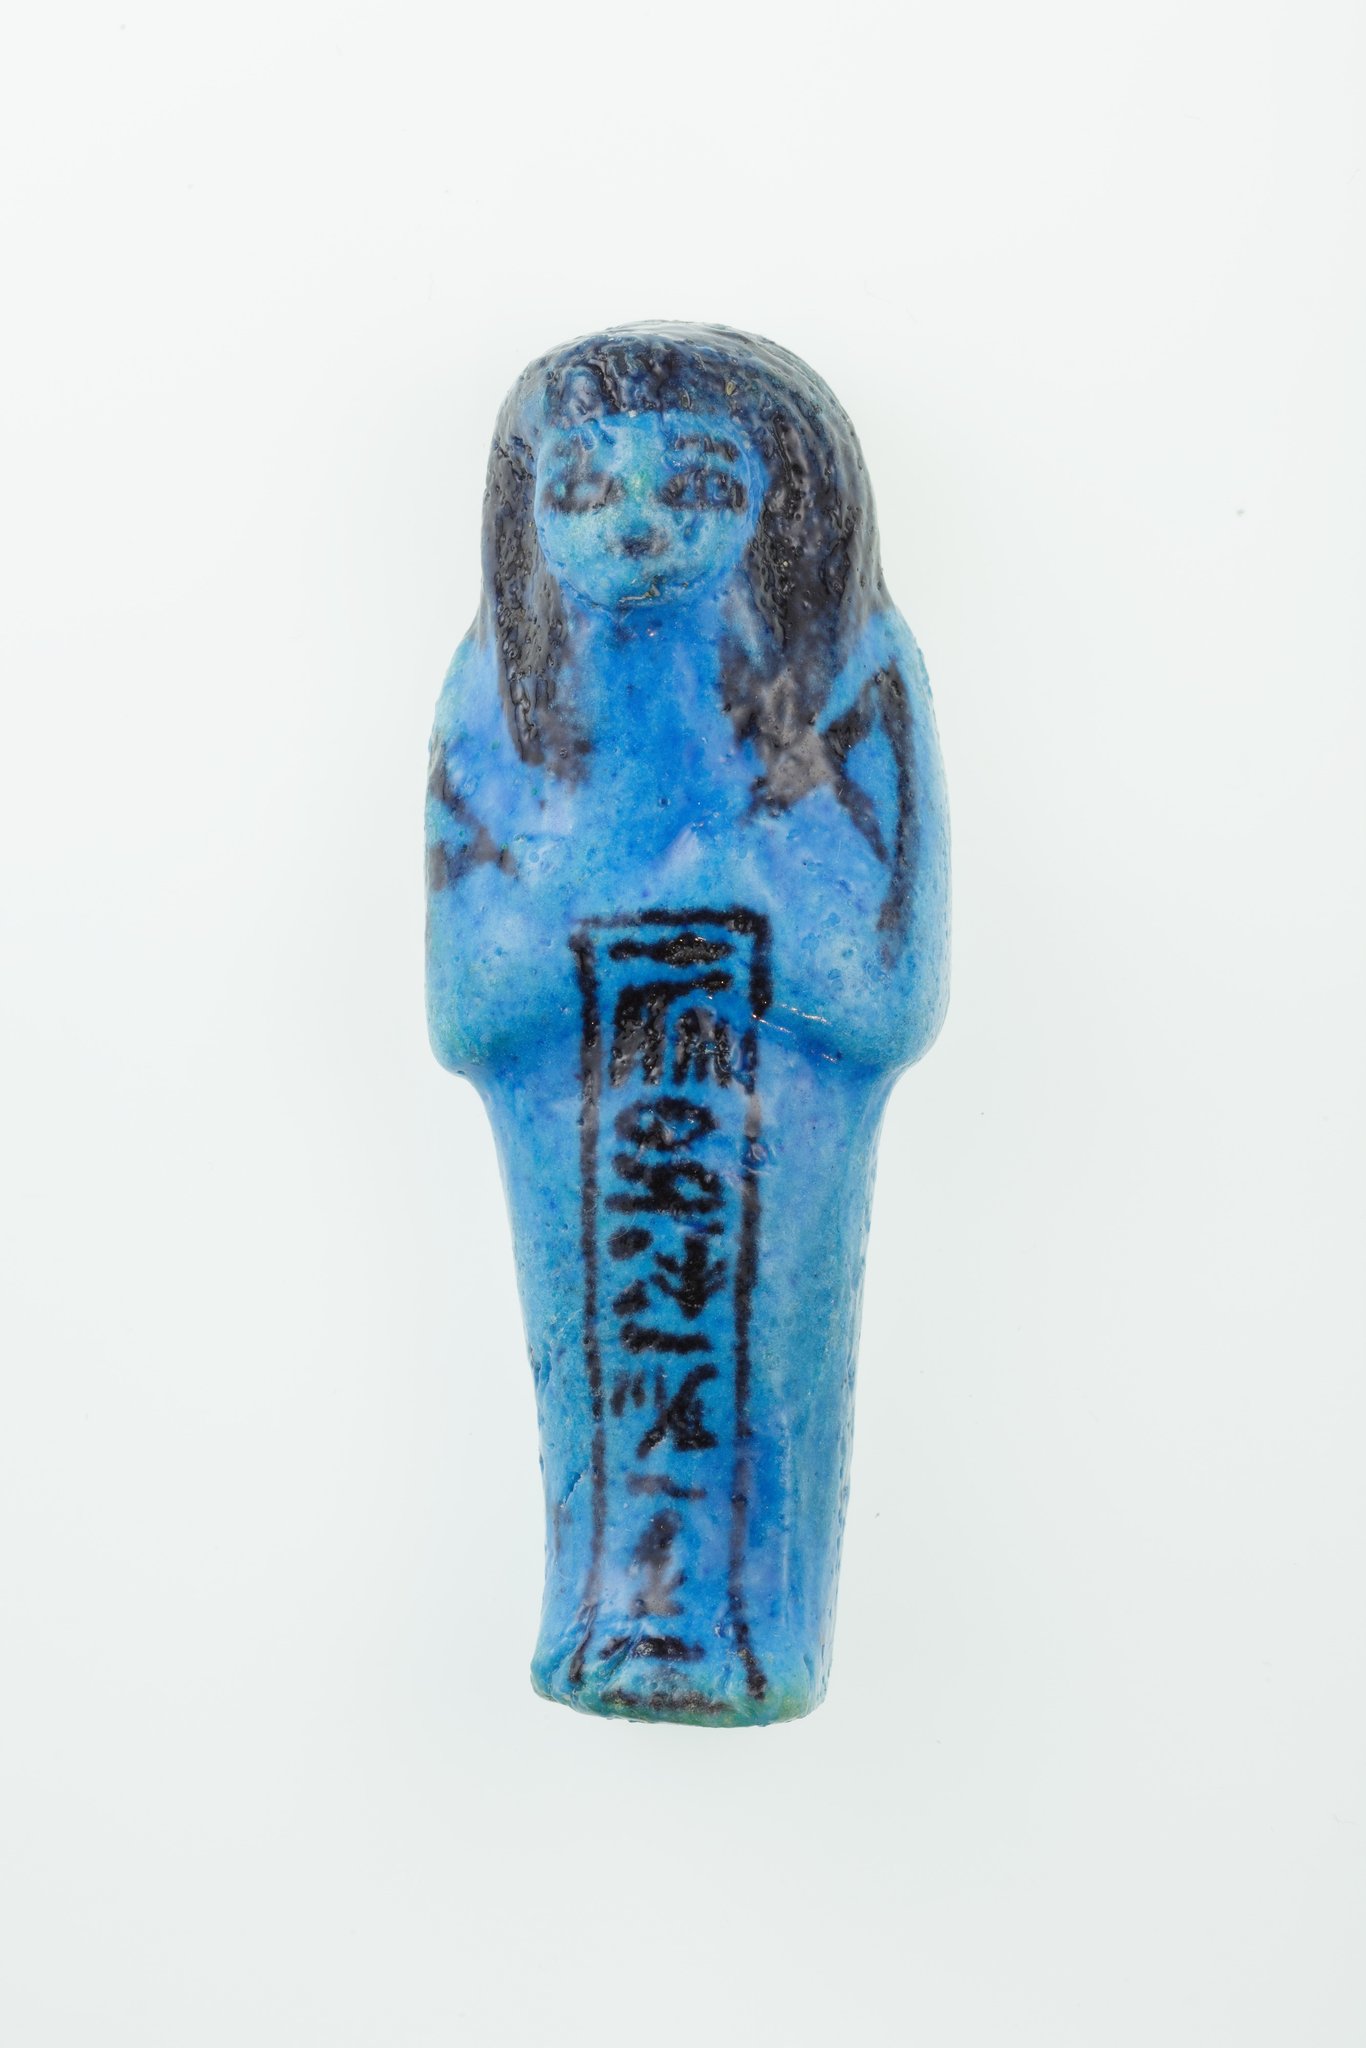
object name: shabti, nauny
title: Worker Shabti of Nauny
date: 1050 BCE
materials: faience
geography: egypt